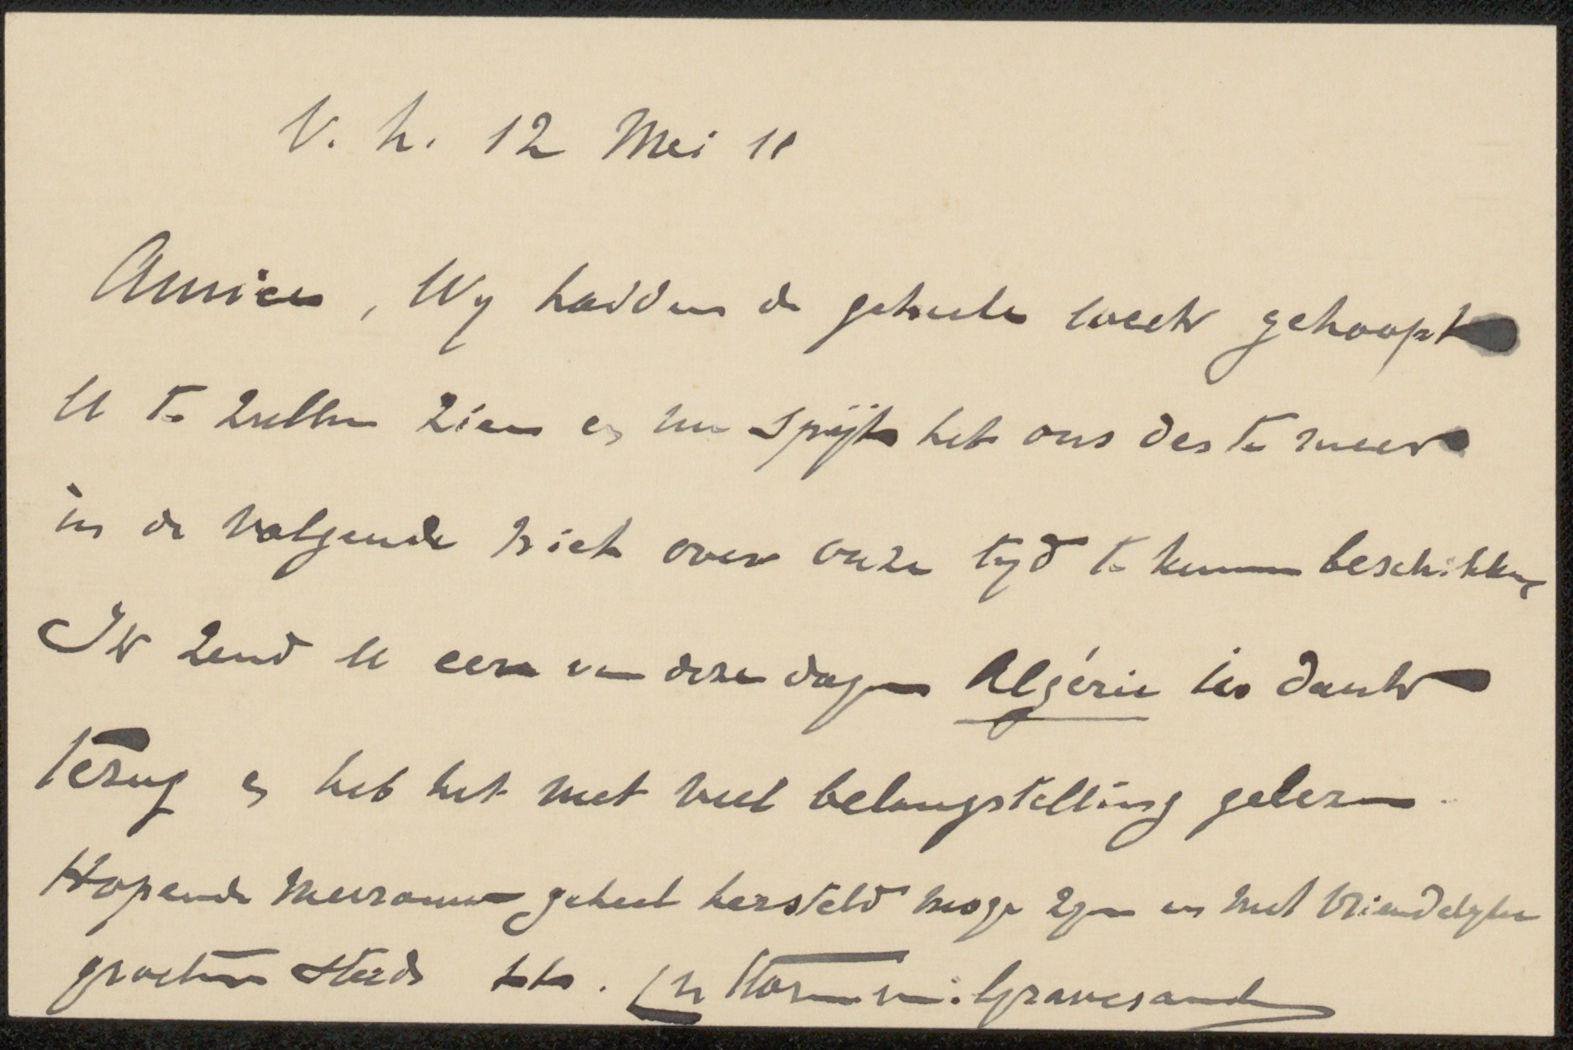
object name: letter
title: Brief aan Philip Zilcken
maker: carel nicolaas storm van s-gravesande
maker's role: draughtsman, print maker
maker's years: 1841-1924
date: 1911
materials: cardboard, ink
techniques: pen, writing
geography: the hague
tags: the hague, painter, draughtsman, philip zilcken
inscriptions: collector's mark: ‘RPK’